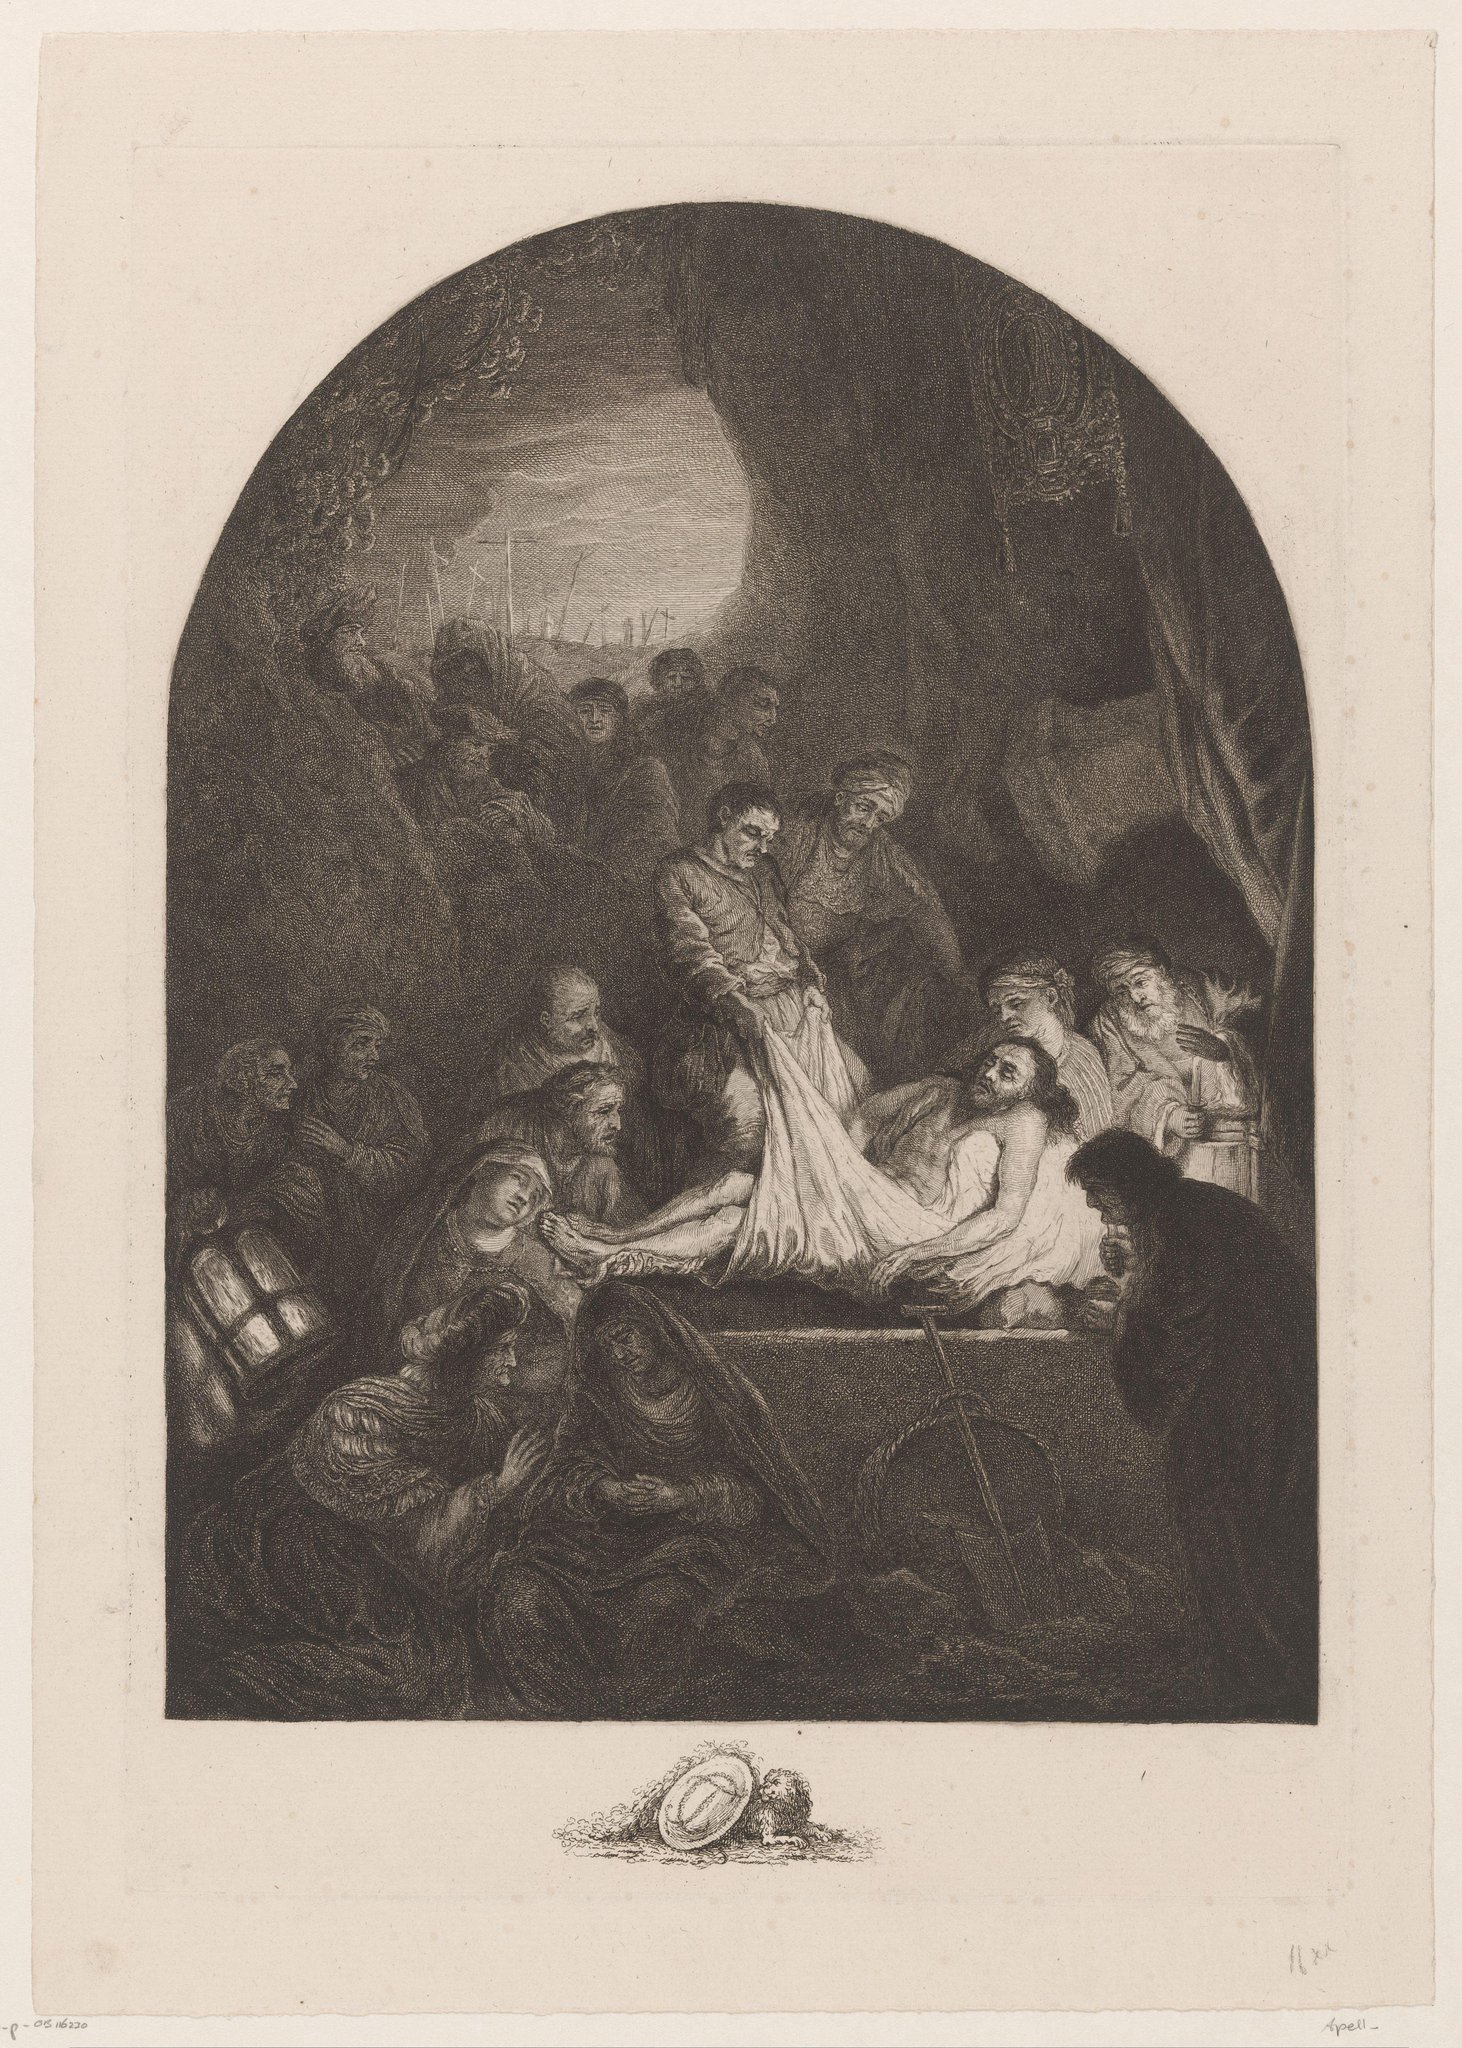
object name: print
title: Graflegging van Christus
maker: carl ernst christoph hess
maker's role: print maker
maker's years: 1755-1828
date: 1765-1828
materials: paper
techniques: etching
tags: christ's entombment (possibly by angels)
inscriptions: collector's mark: Lugt 240